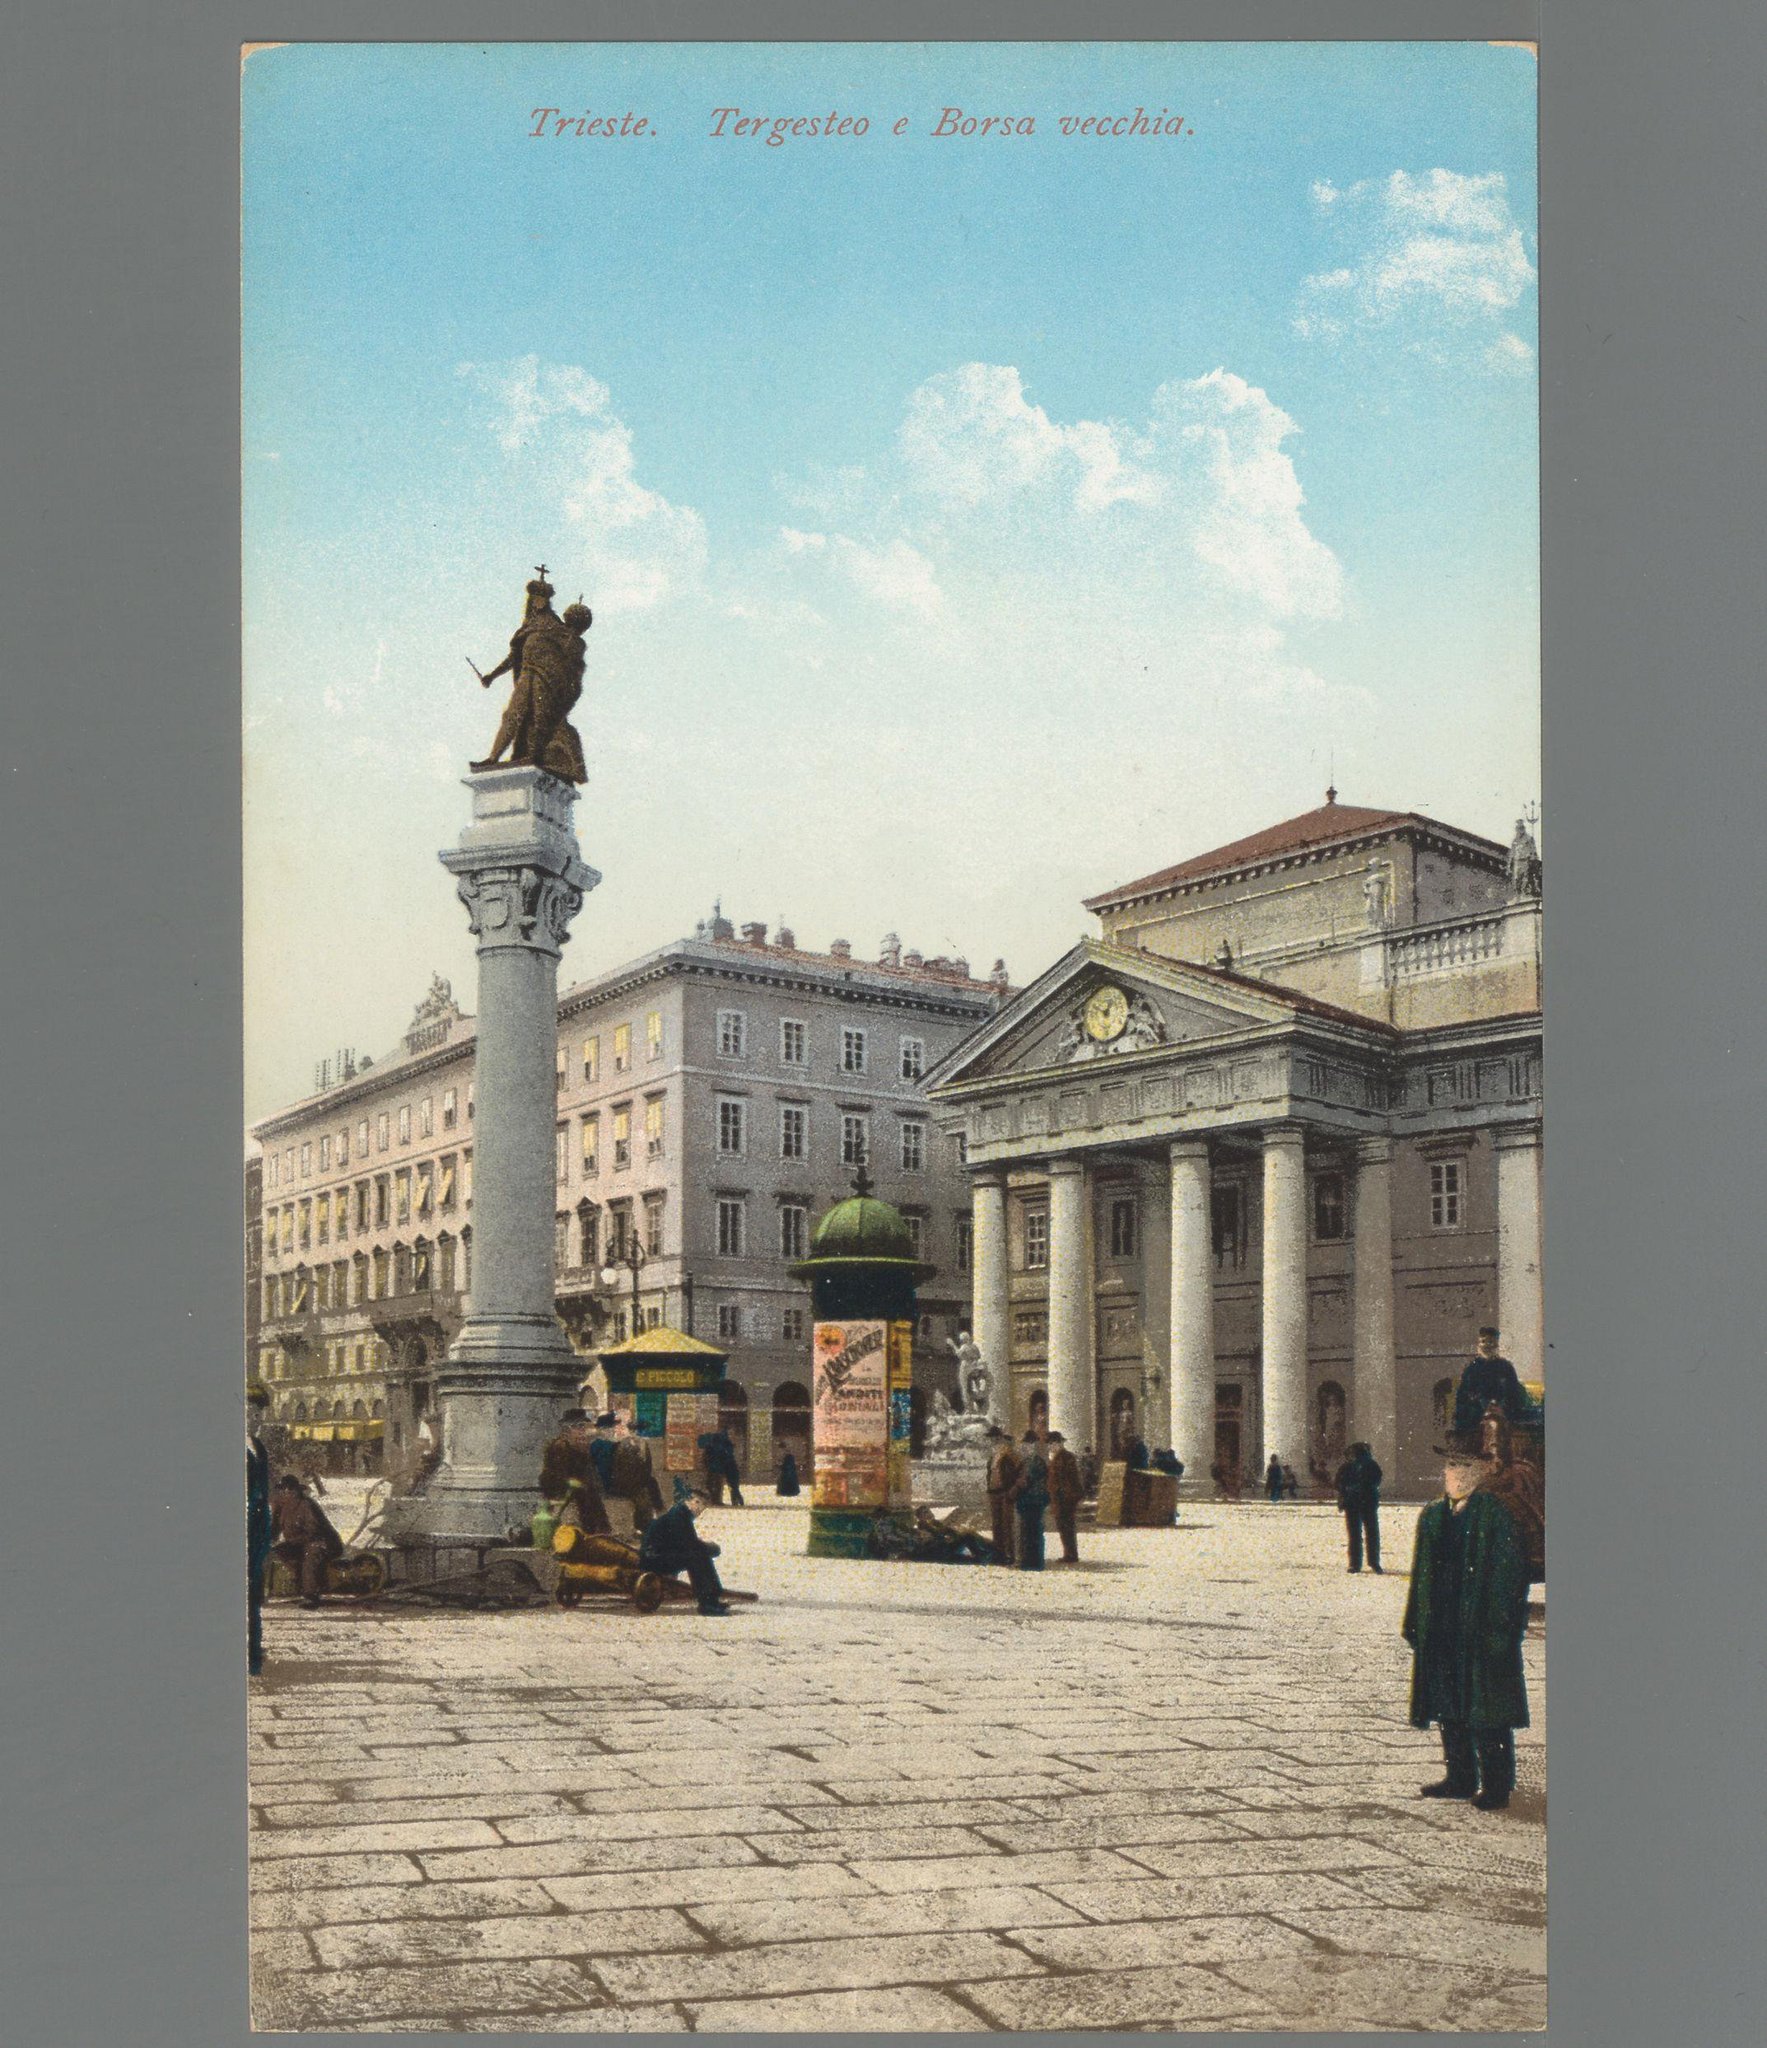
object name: ansichtkaart, prentbriefkaart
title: Trieste. Tergesteo e Borsa vecchia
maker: Anonymous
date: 1906-1909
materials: cardboard, photographic process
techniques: writing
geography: trieste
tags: monument, statue, exchange, bourse, square, place, circus, etc. (+ city(-scape) with figures, staffage)